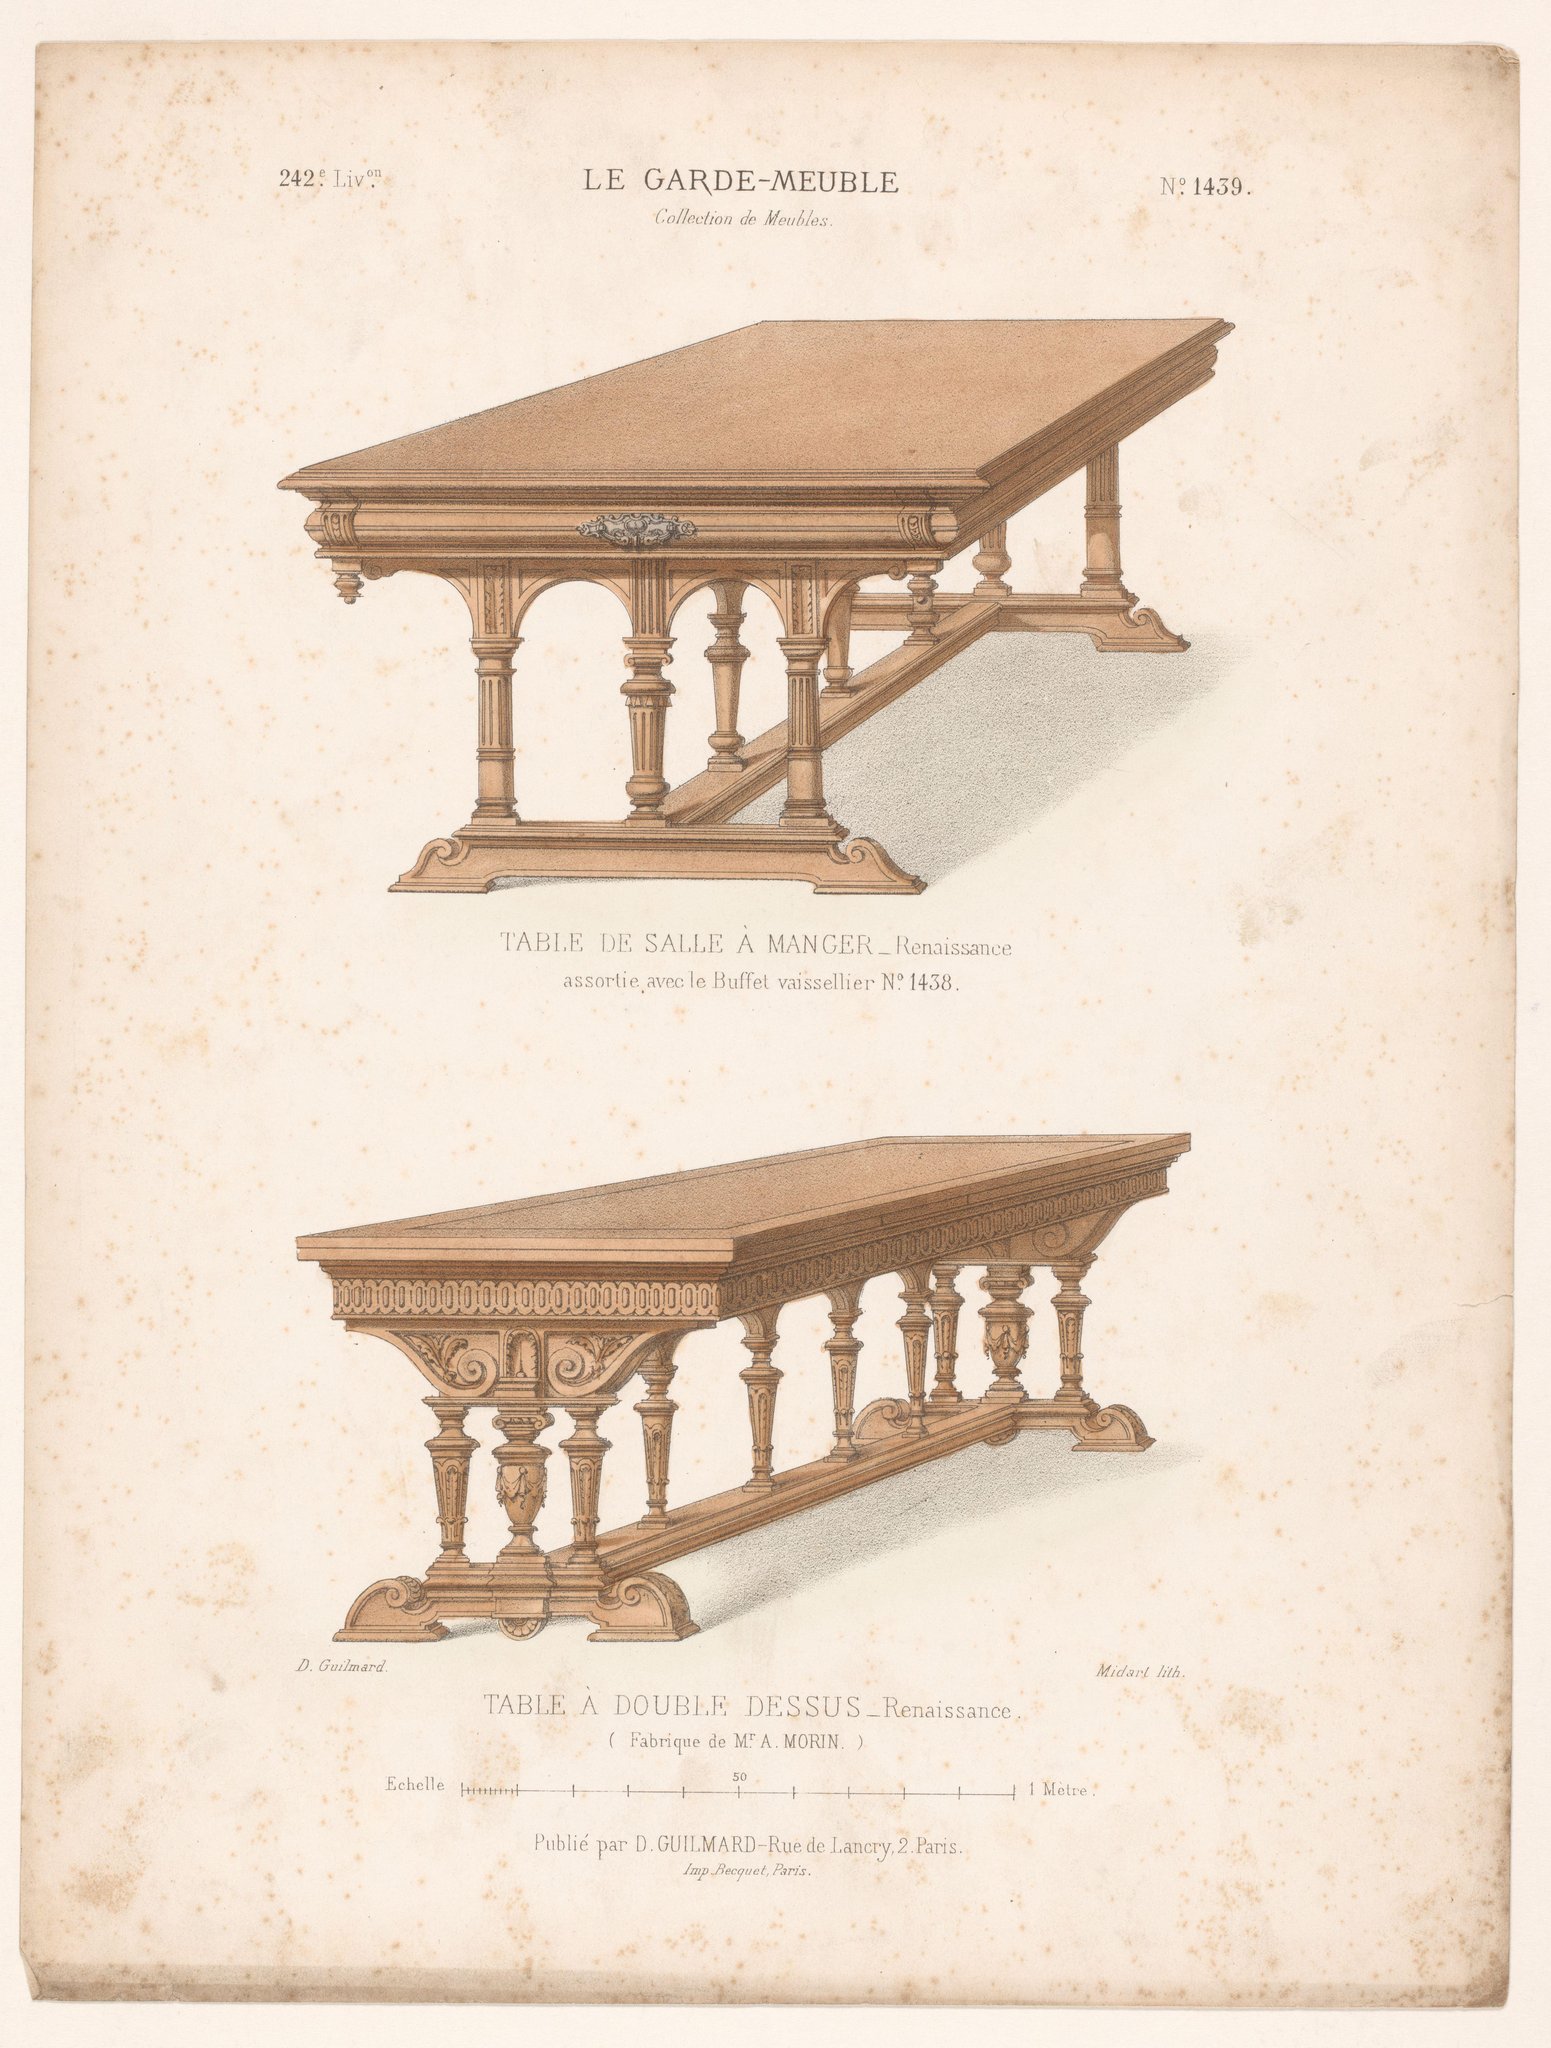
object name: print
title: Twee tafels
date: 1839-1885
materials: paper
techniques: hand coloring, lithograph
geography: paris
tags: table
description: Ieder Livraison in de serie Le Garde-Meuble bevat negen platen: drie 'sièges' (zitmeubels), drie 'meubles' (diverse meubels zoals tafels en kasten) en drie 'tentures' (gordijnen en draperieën).